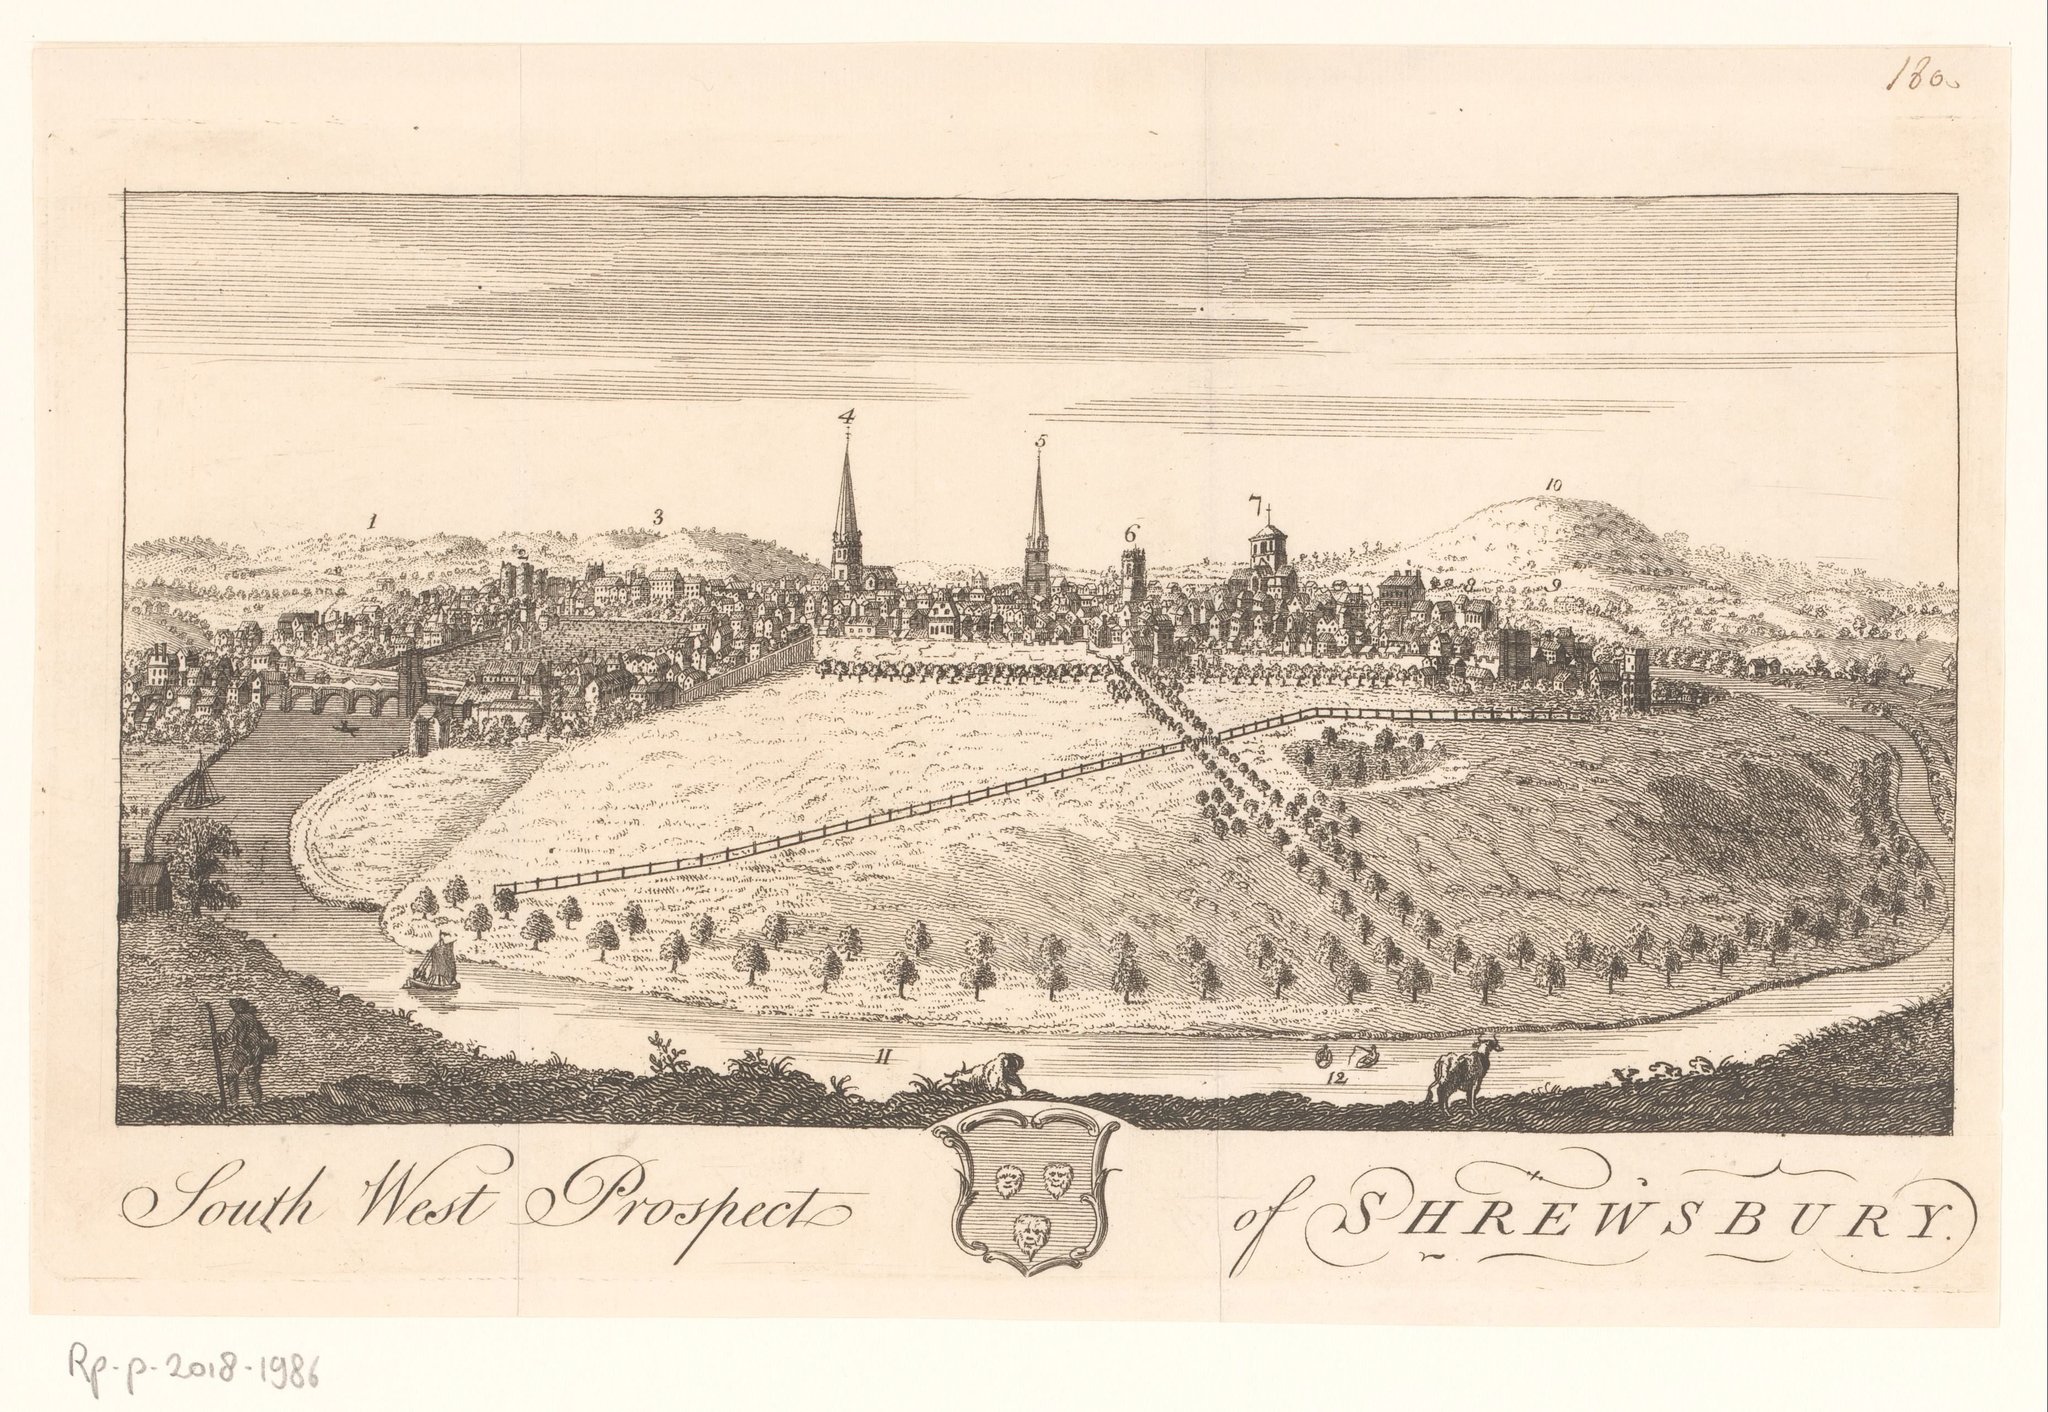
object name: print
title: South west prospect of Shrewsbury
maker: Anonymous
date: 1741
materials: paper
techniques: engraving, etching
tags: prospect of city, town panorama, silhouette of city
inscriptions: collector's mark: Lugt 2228